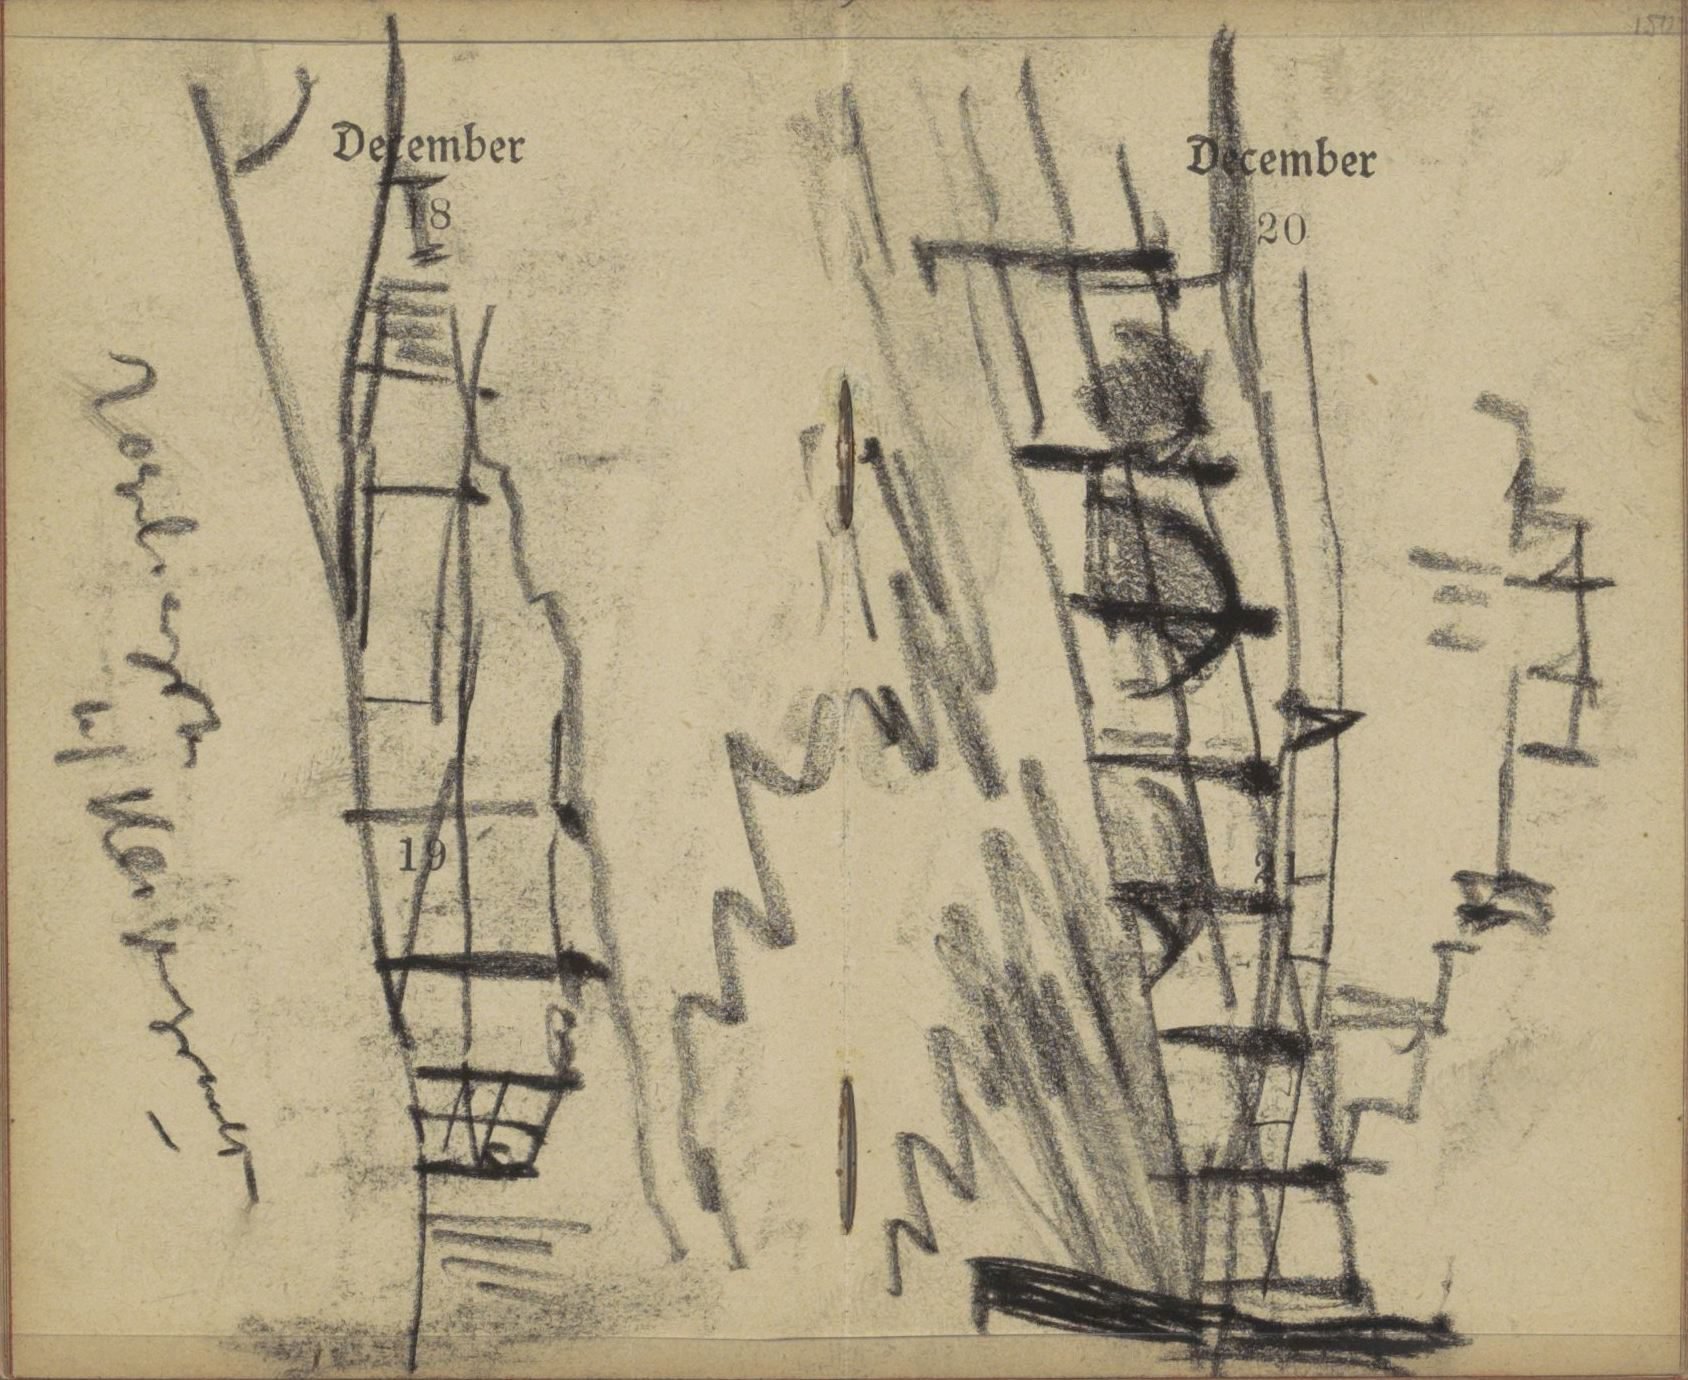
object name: sketchbook leaf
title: Gezicht op de brug over de Keizersgracht te Amsterdam ter hoogte van de Reguliersgracht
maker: george hendrik breitner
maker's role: draughtsman, painter, print maker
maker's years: 1857-1923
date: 1893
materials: chalk, paper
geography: amsterdam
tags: bridge in city across river, canal, etc., civic architecture; edifices; dwellings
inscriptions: annotation: ‘Reguliersgracht/ b/ Keizersgracht’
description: Pagina 149 en pagina 150 uit een als schetsboek gebruikte agenda met 80 bladen.